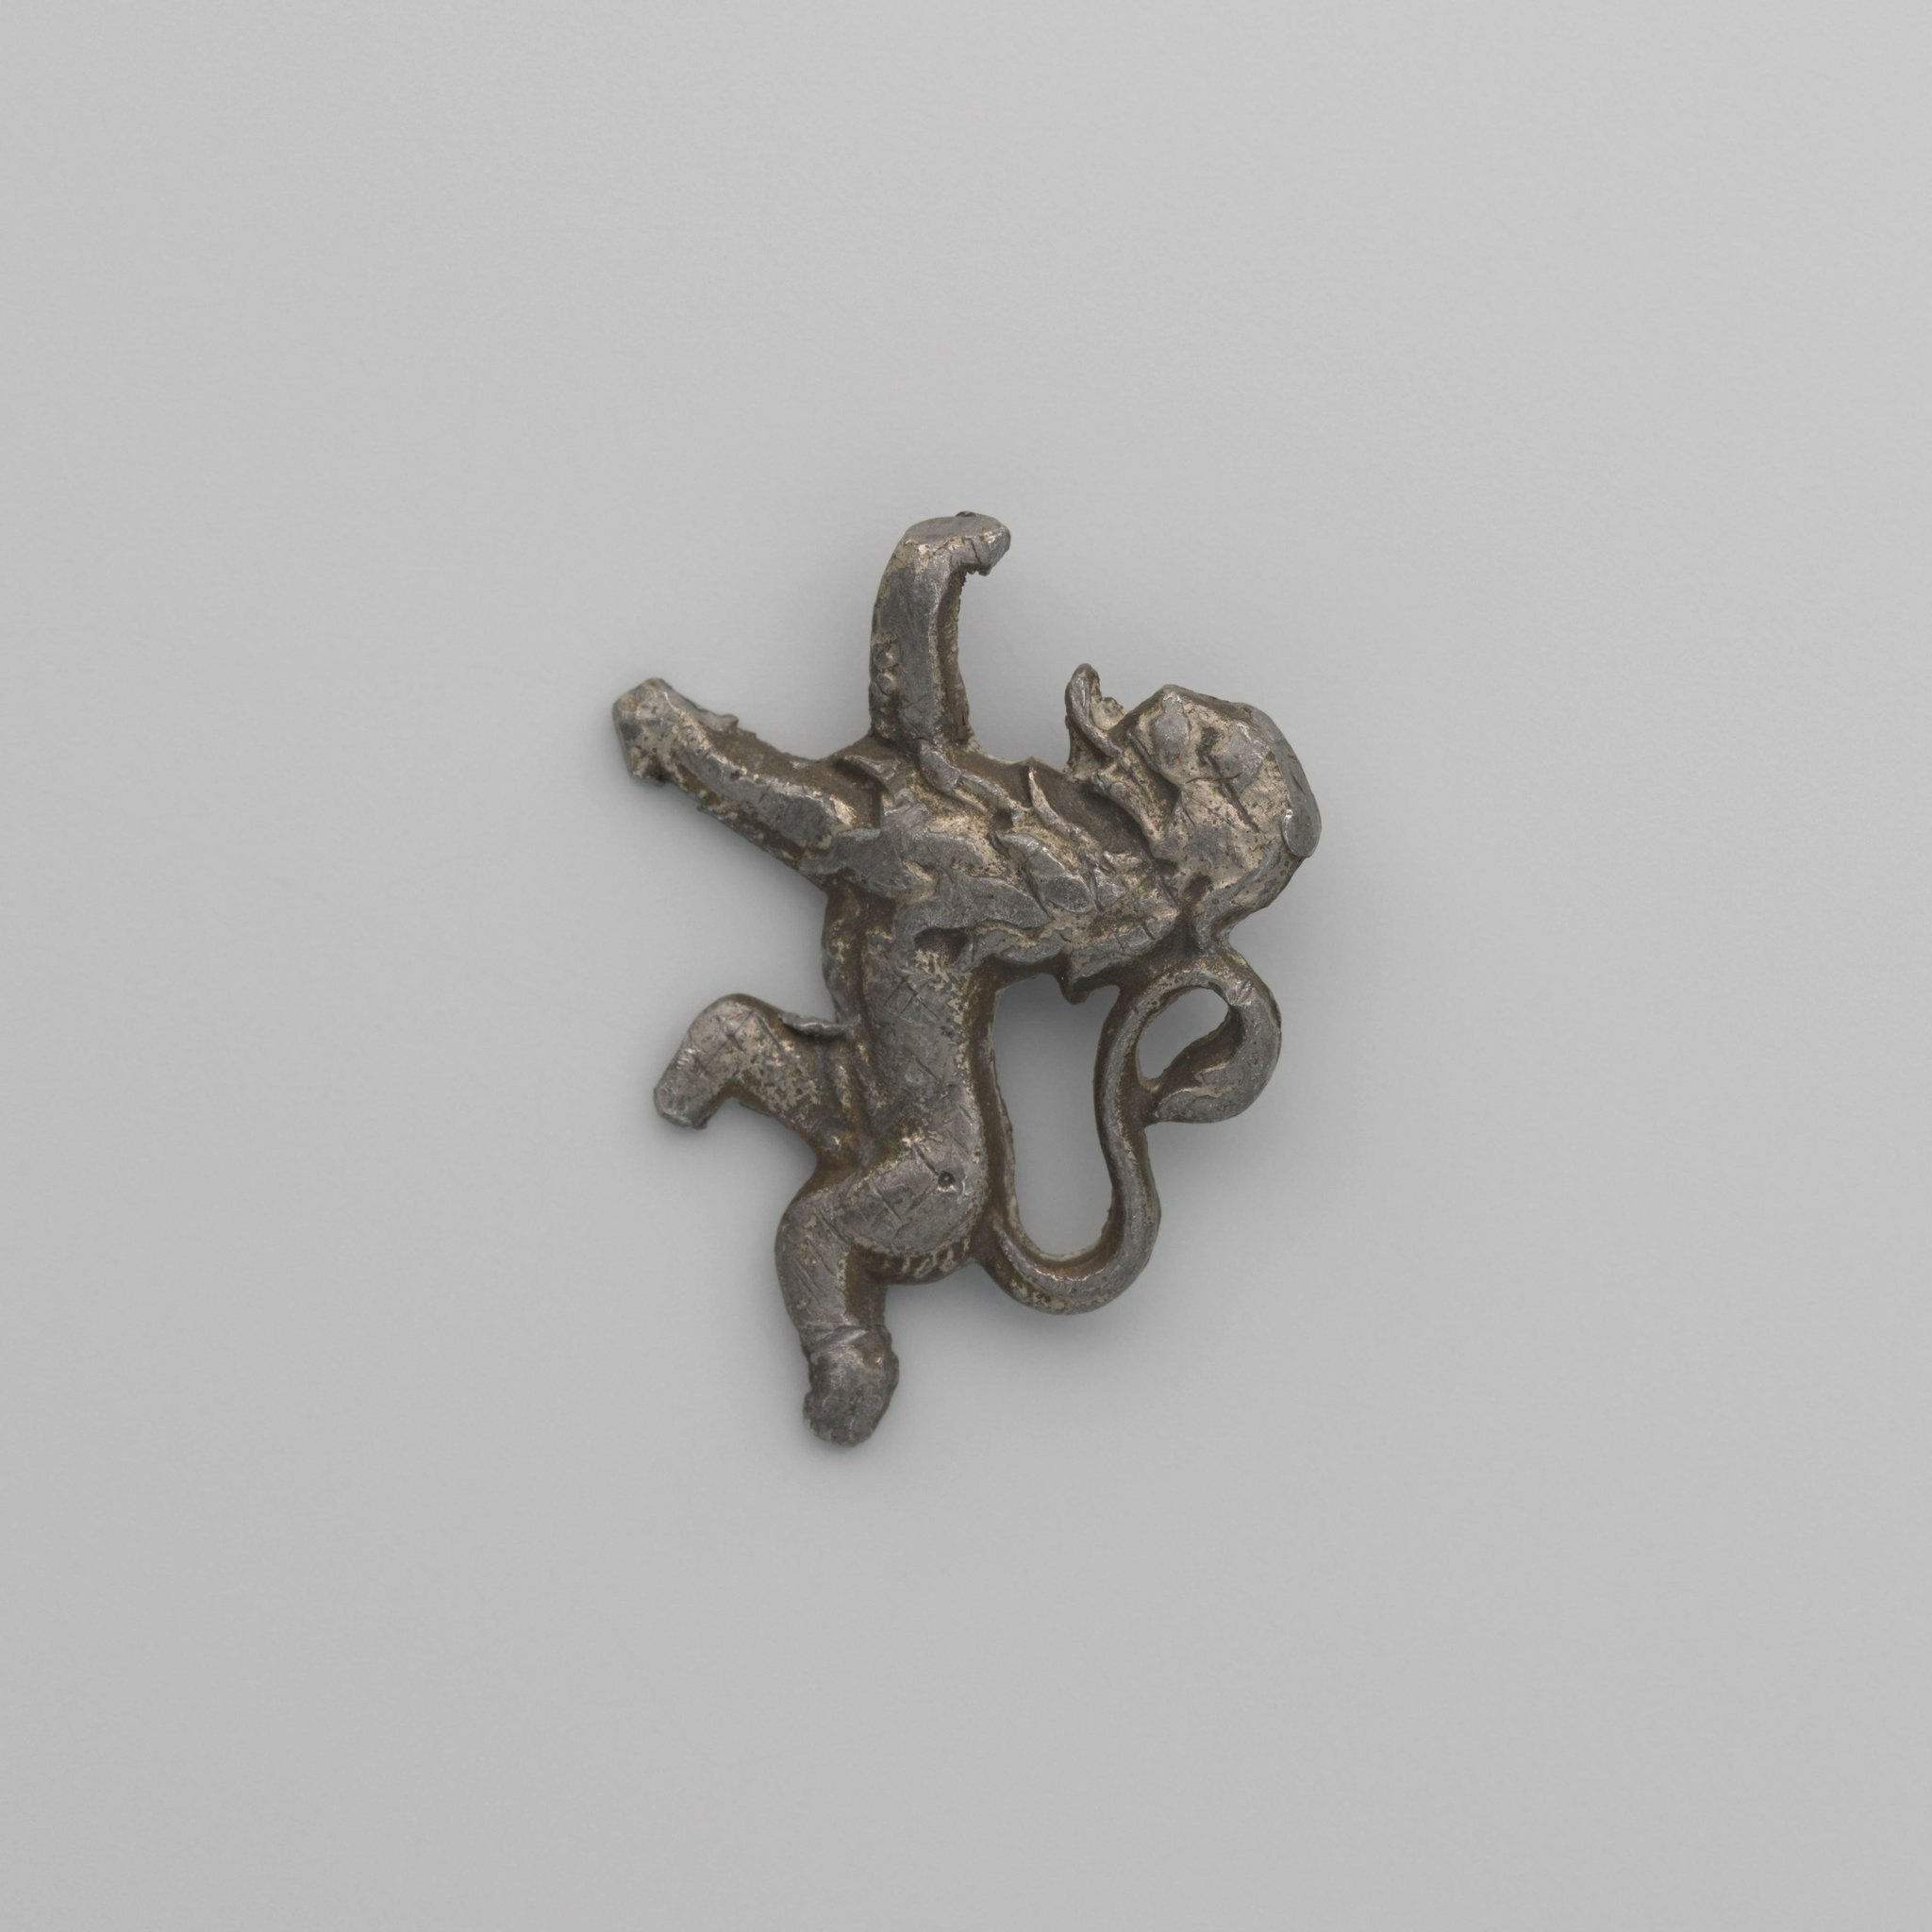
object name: brooch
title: Fragment van een broche van metaal in de vorm van een Nederlandse klimmende leeuw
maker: Anonymous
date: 1940-1945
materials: metal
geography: netherlands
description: Fragment van een broche van metaal in de vorm van een Nederlandse klimmende leeuw. Van de sluiting is alleen de haak aanwezig. Uit een ensemble van elf stuks van mejuffrouw Henriquez de Castro.